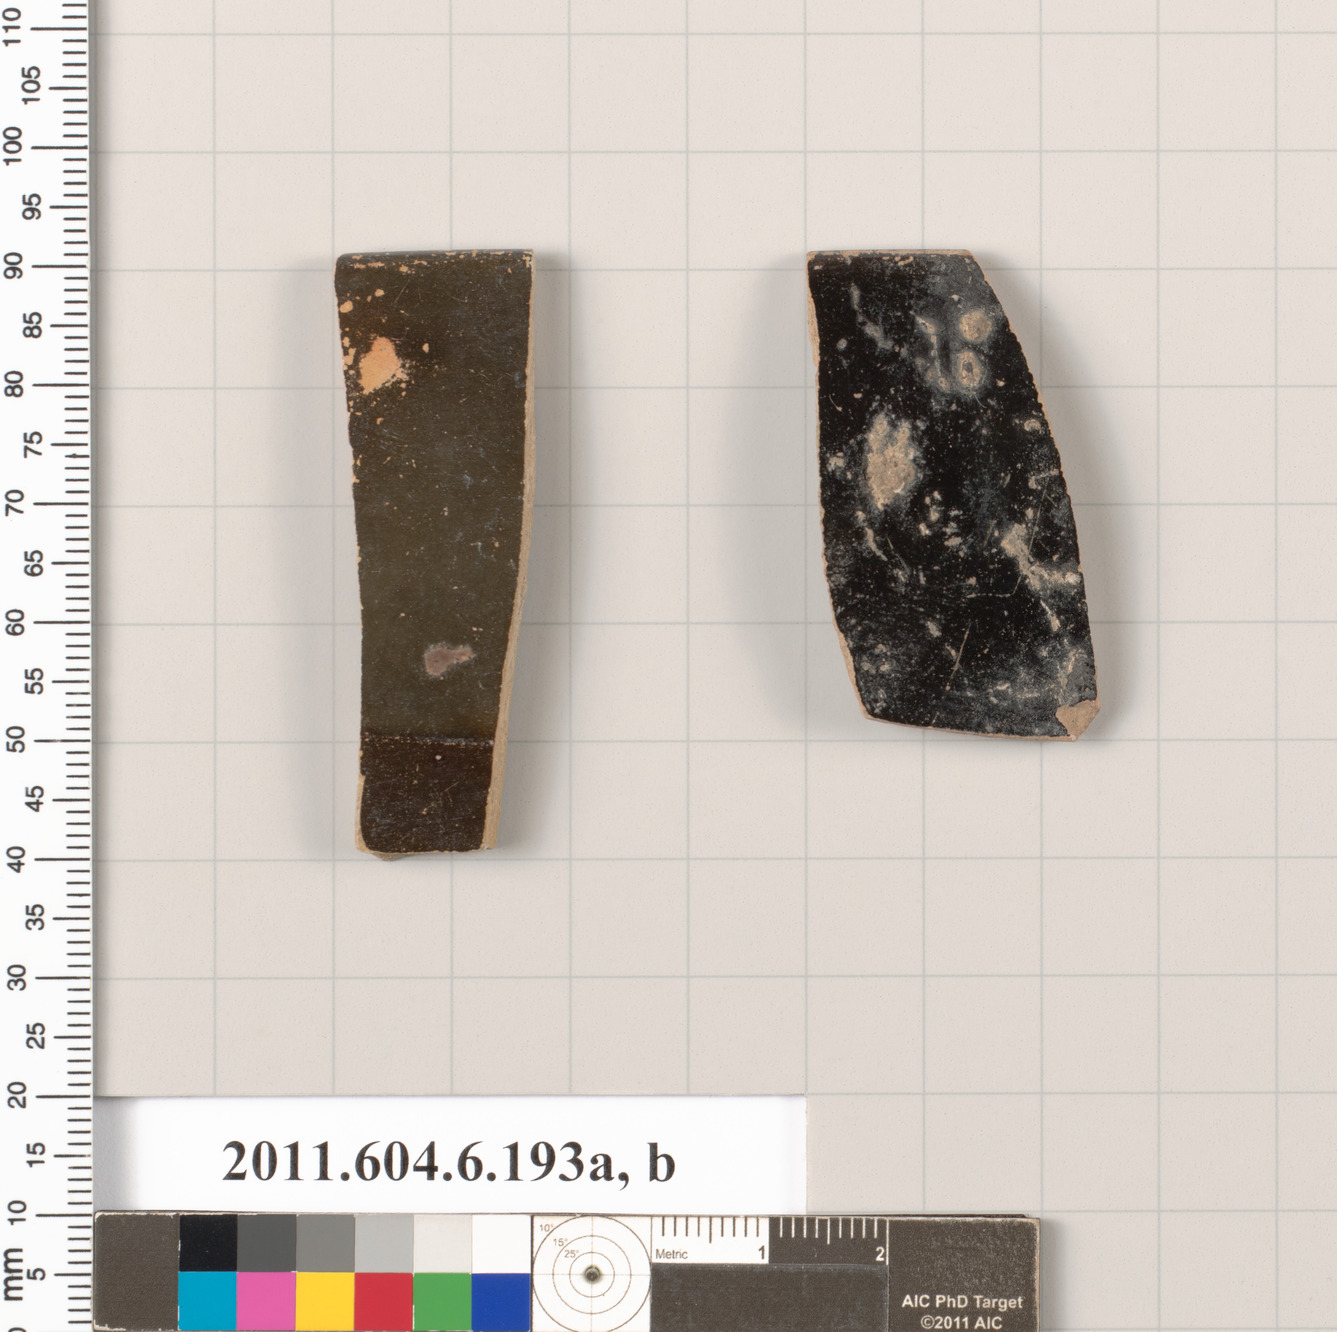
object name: skyphos fragment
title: Terracotta rim fragments of skyphoi (deep drinking cups)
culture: greek, attic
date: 500-401 BCE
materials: terracotta